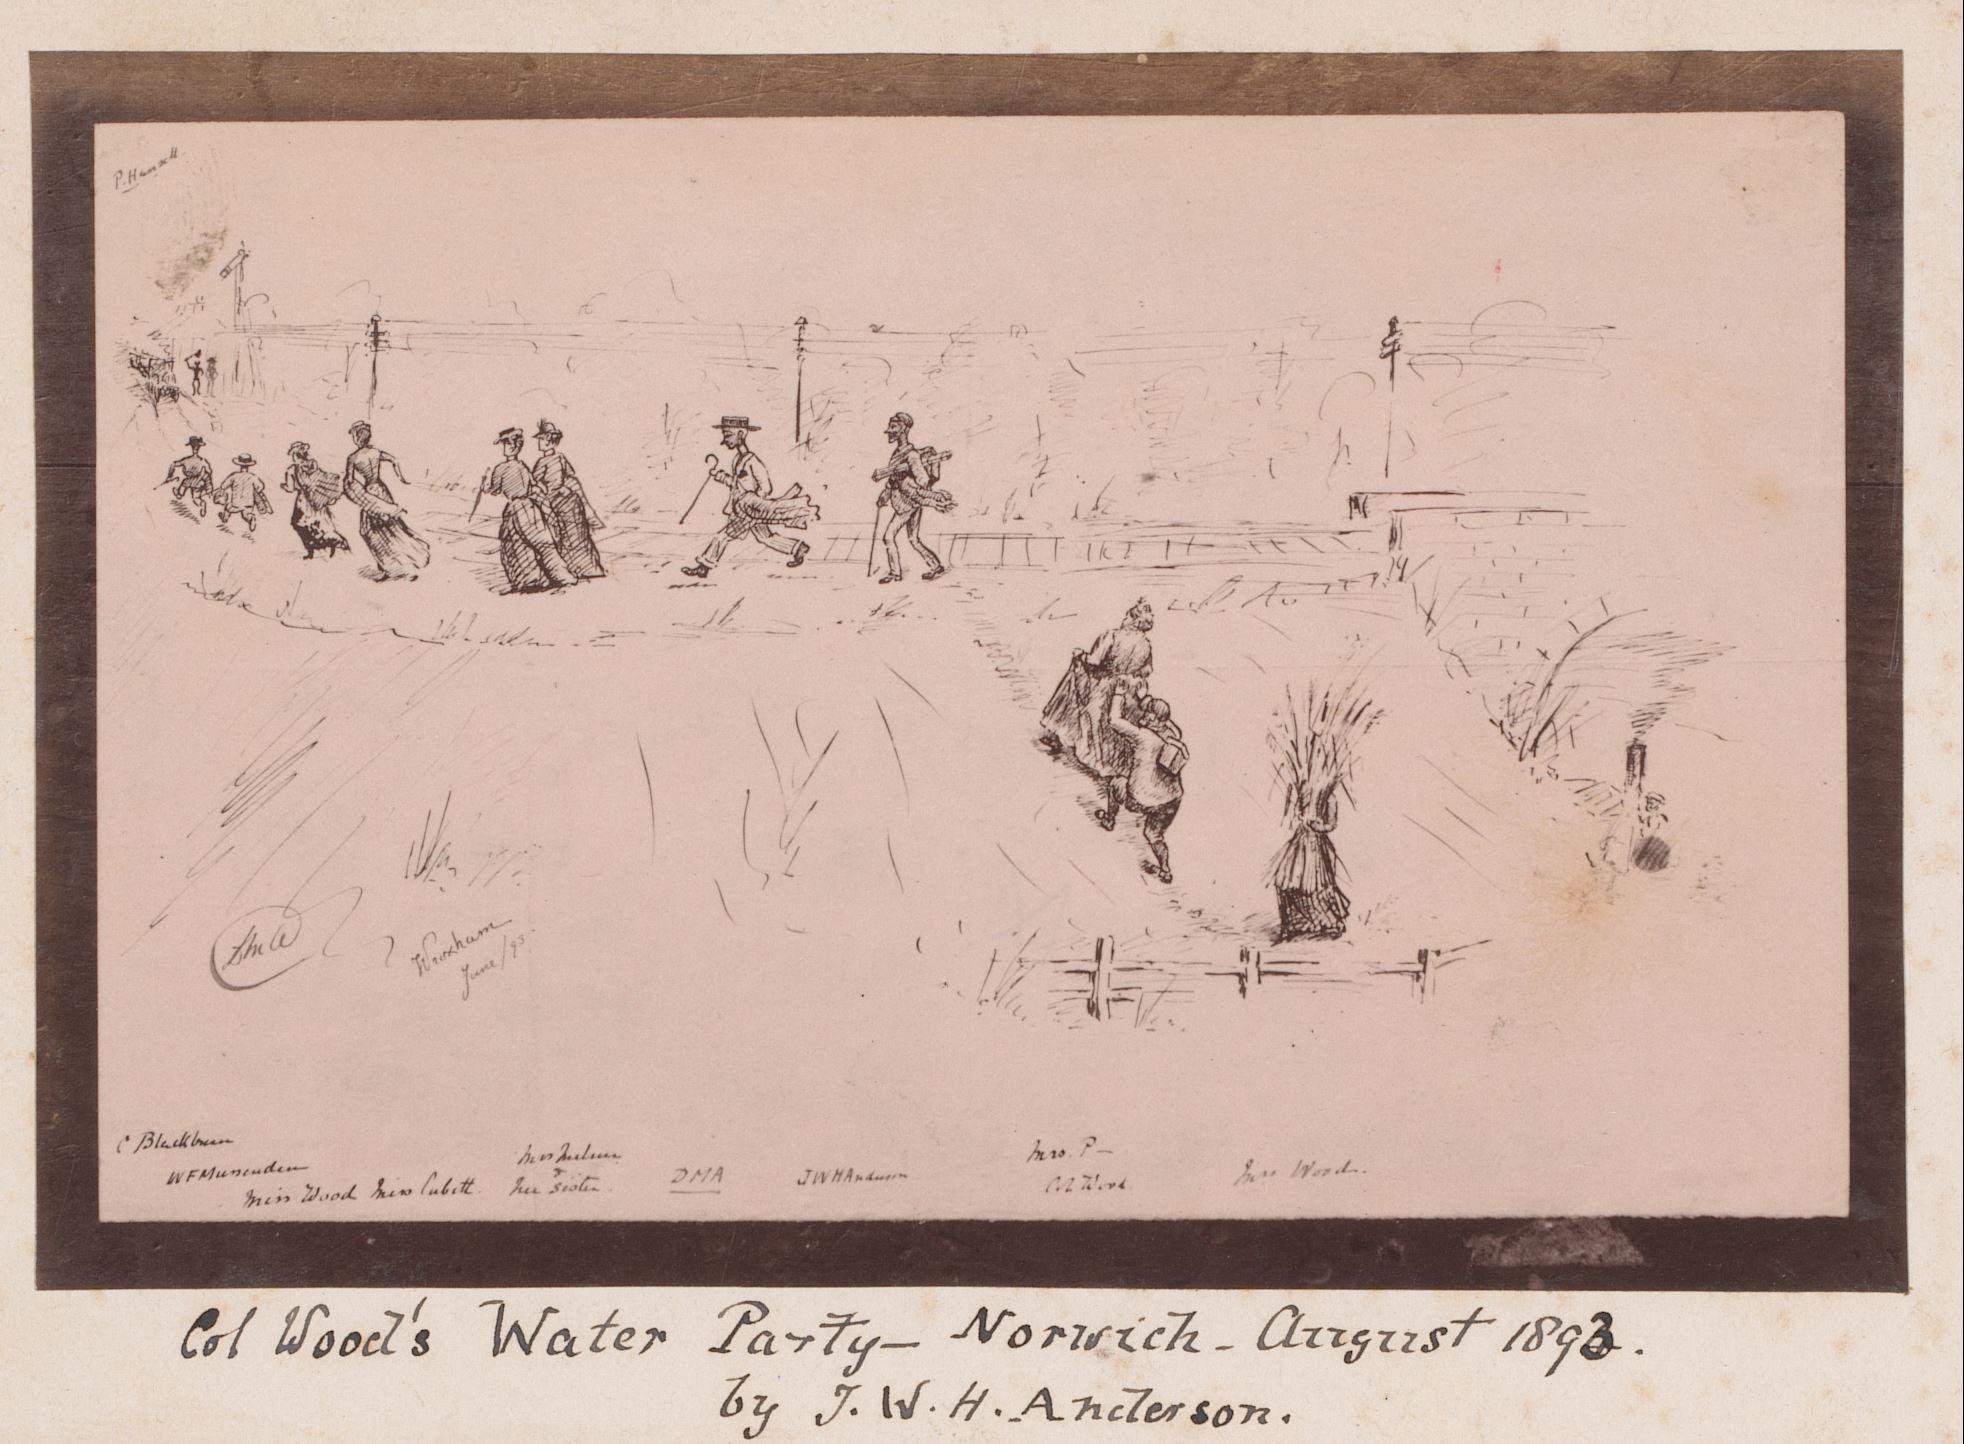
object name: album leaf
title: Fotografische reproductie van een schets "Col Wood's Water Party - Norwich - August 1893" door J.W.H. Anderson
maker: Anonymous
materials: cardboard, paper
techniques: albumen print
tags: norwich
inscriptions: caption: ‘Col Wood's Water Party - Norwich - August 1893//by J.W.H. Anderson’